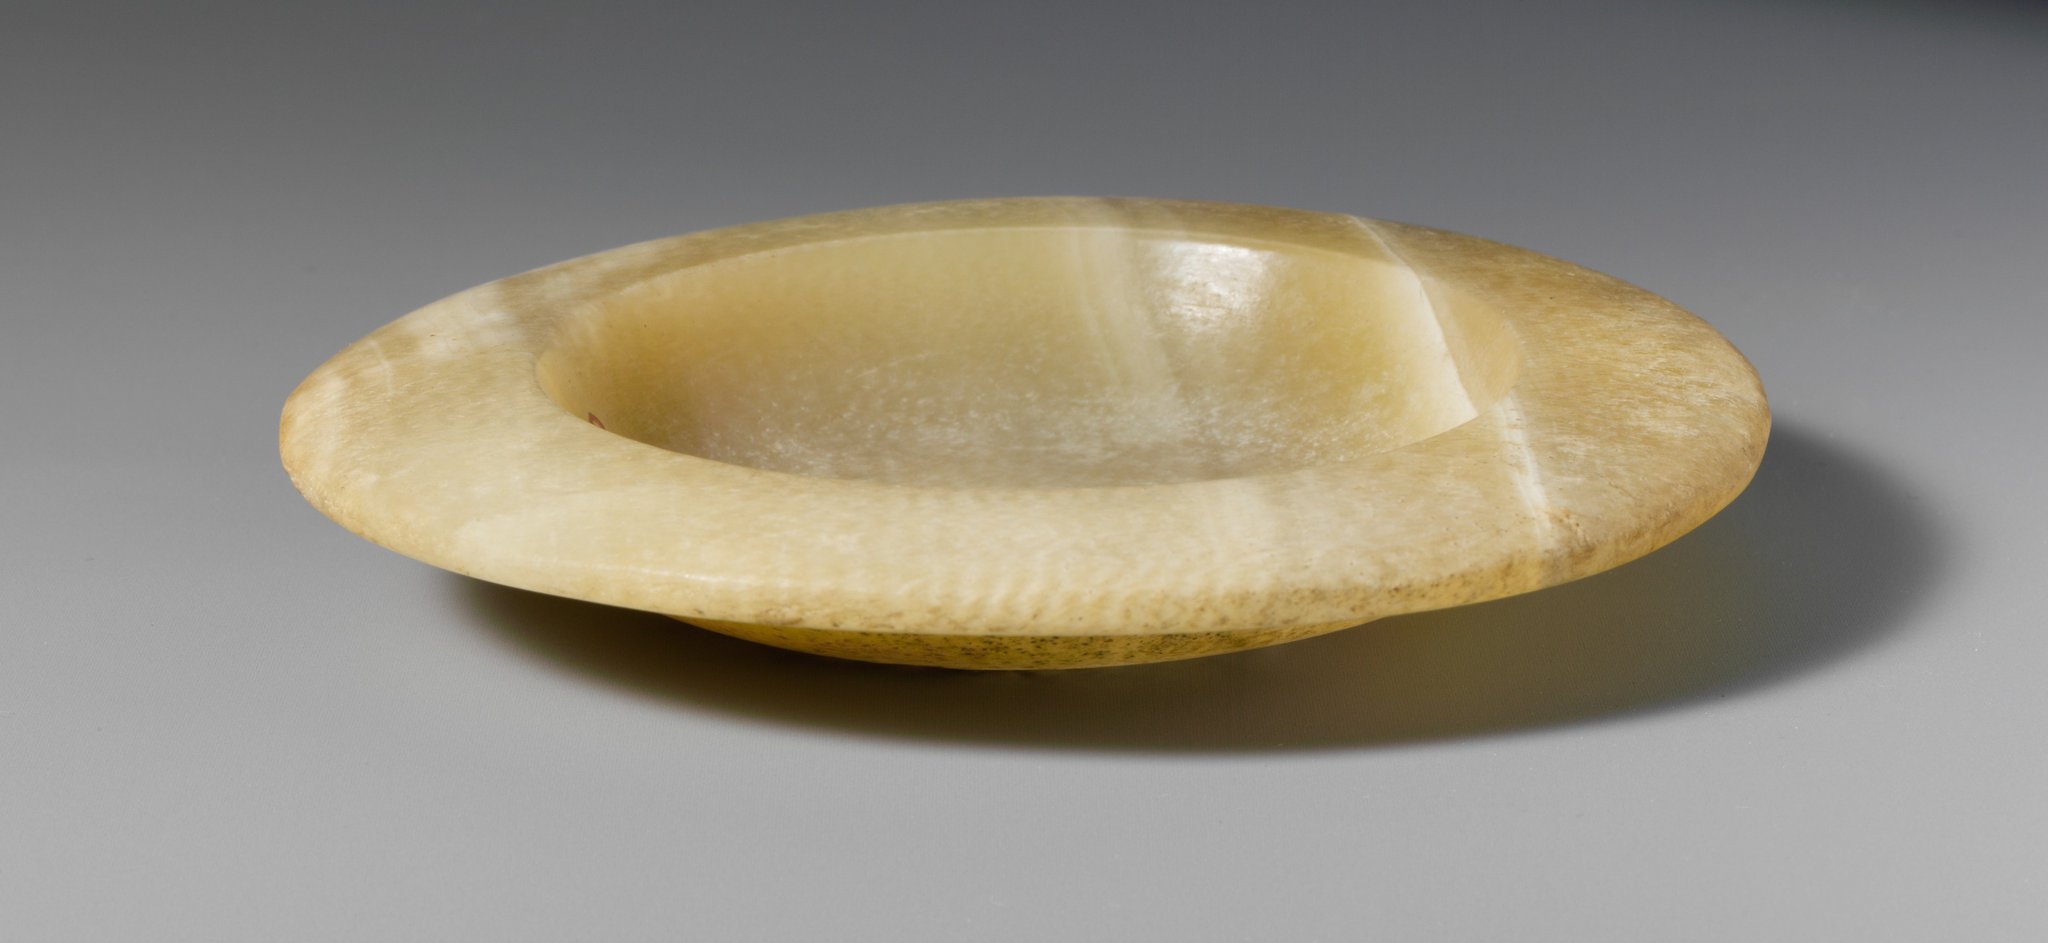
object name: dish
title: Alabaster dish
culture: cypriot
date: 400-301 BCE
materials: alabaster